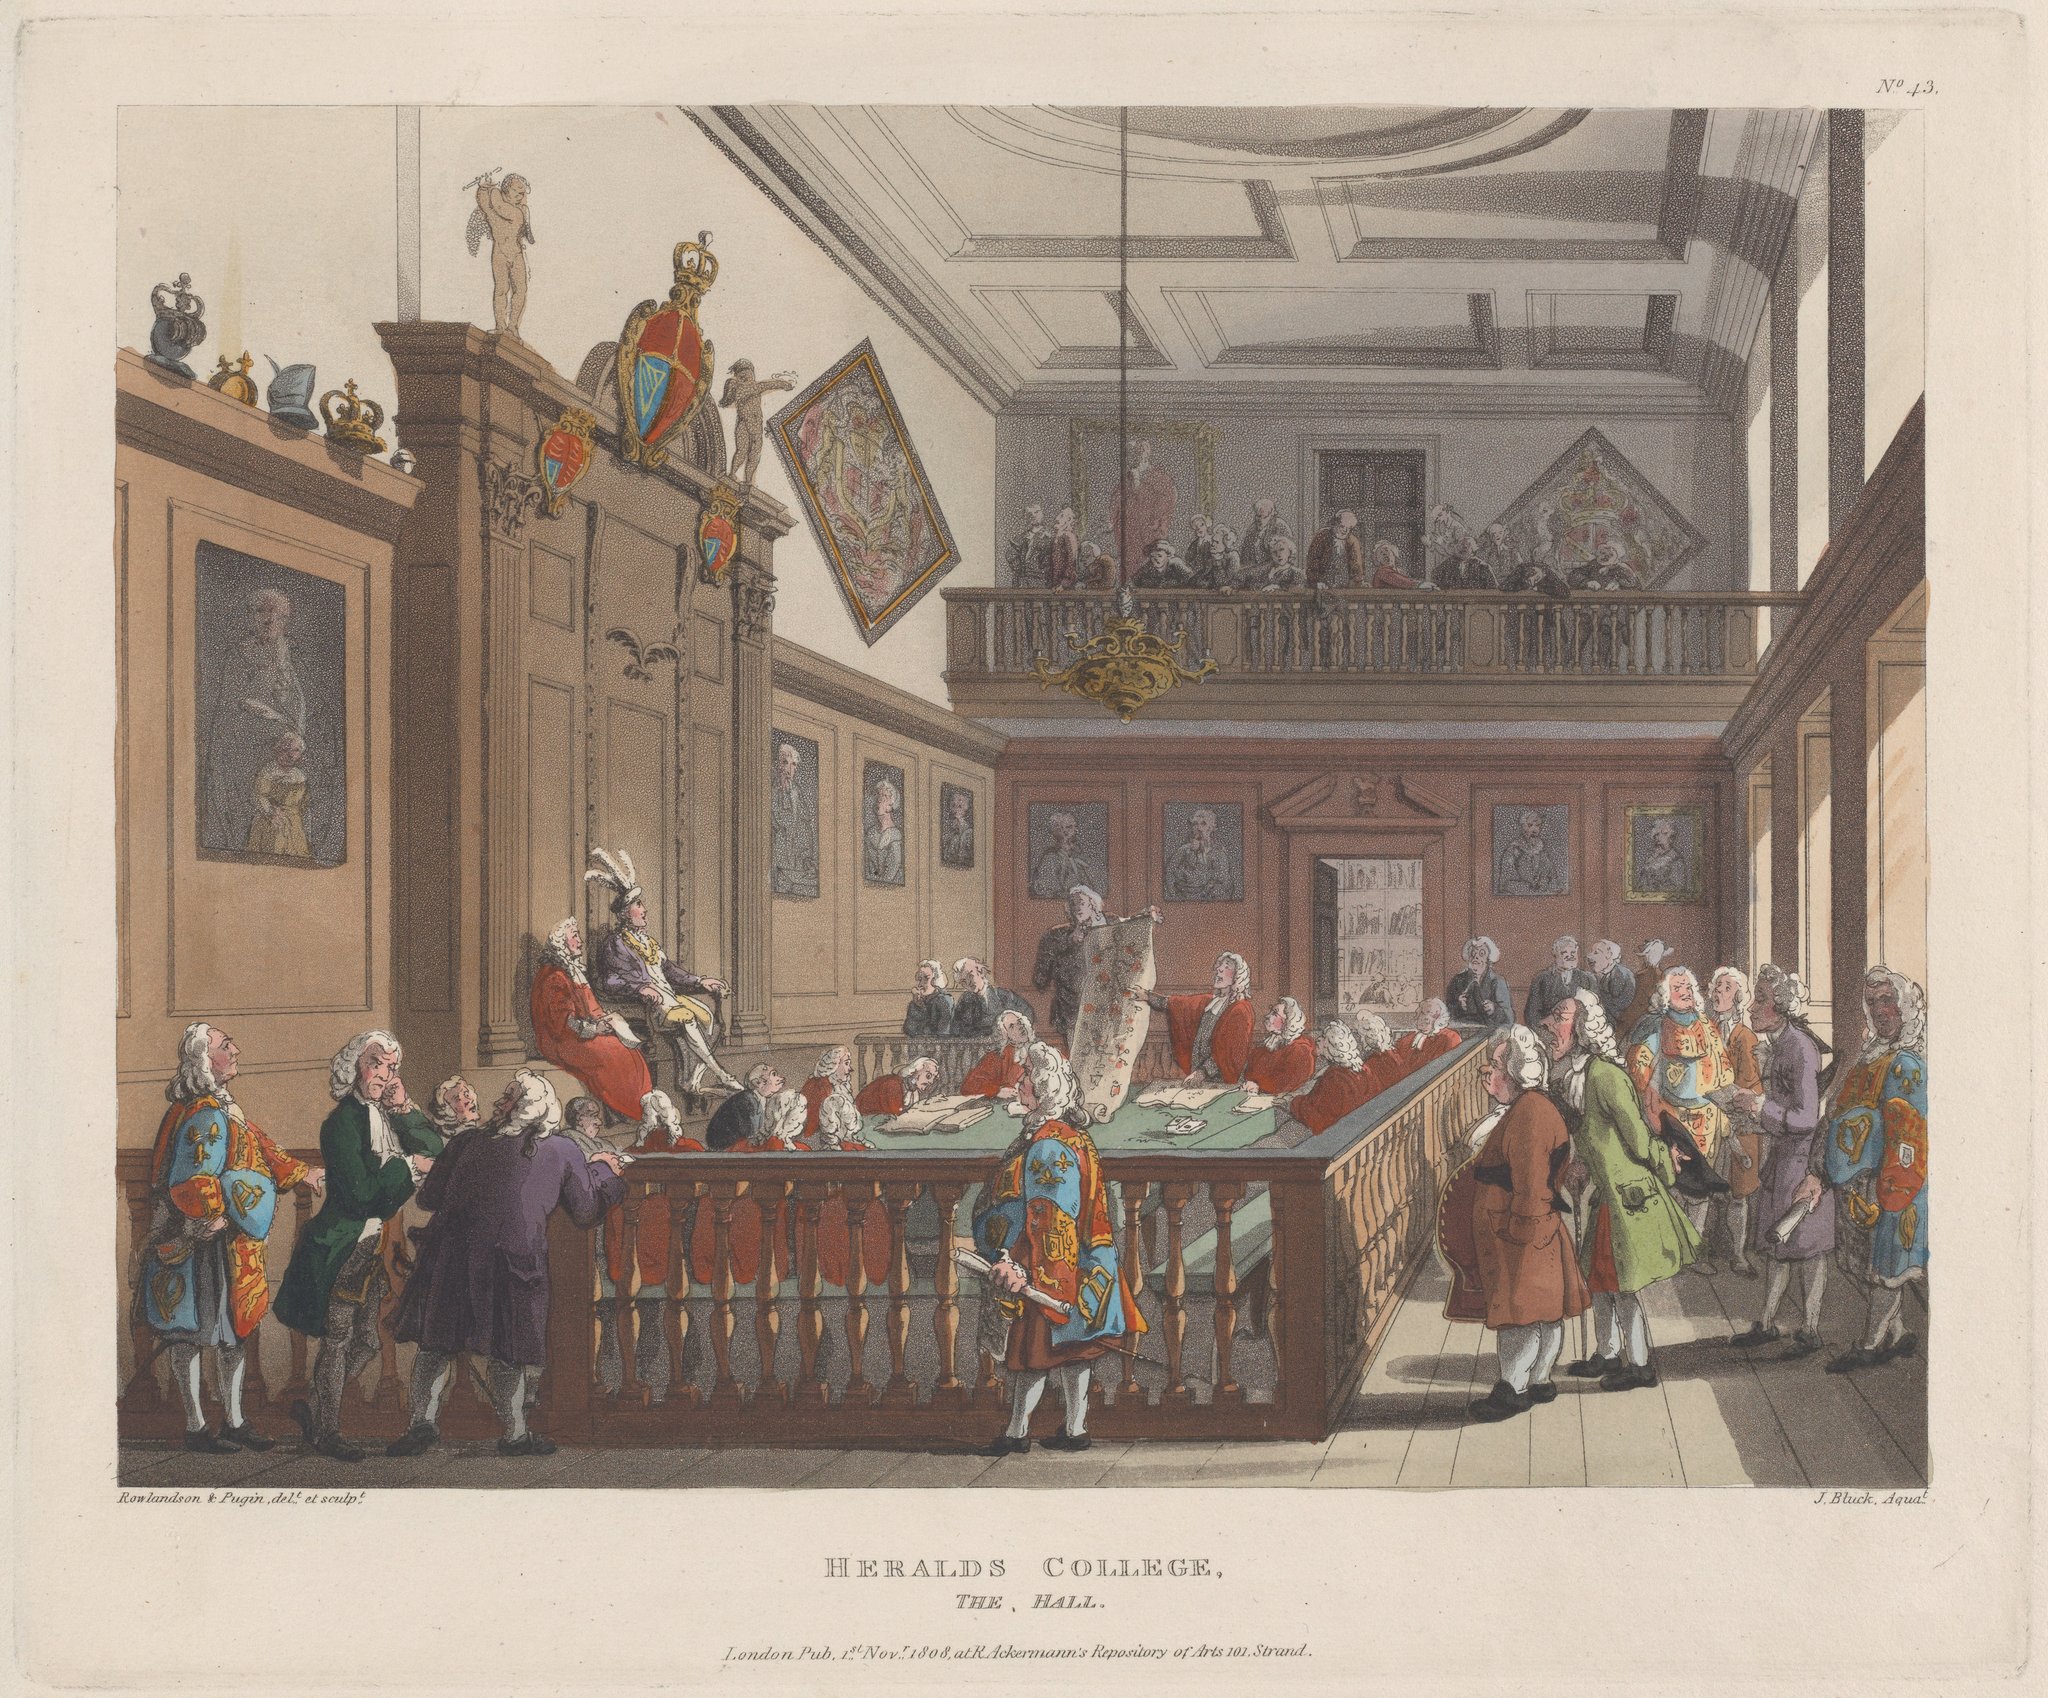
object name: print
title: Herald's College, The Hall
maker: thomas rowlandson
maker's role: artist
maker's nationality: british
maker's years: 1757-1827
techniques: aquatint, etching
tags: interiors,men,law